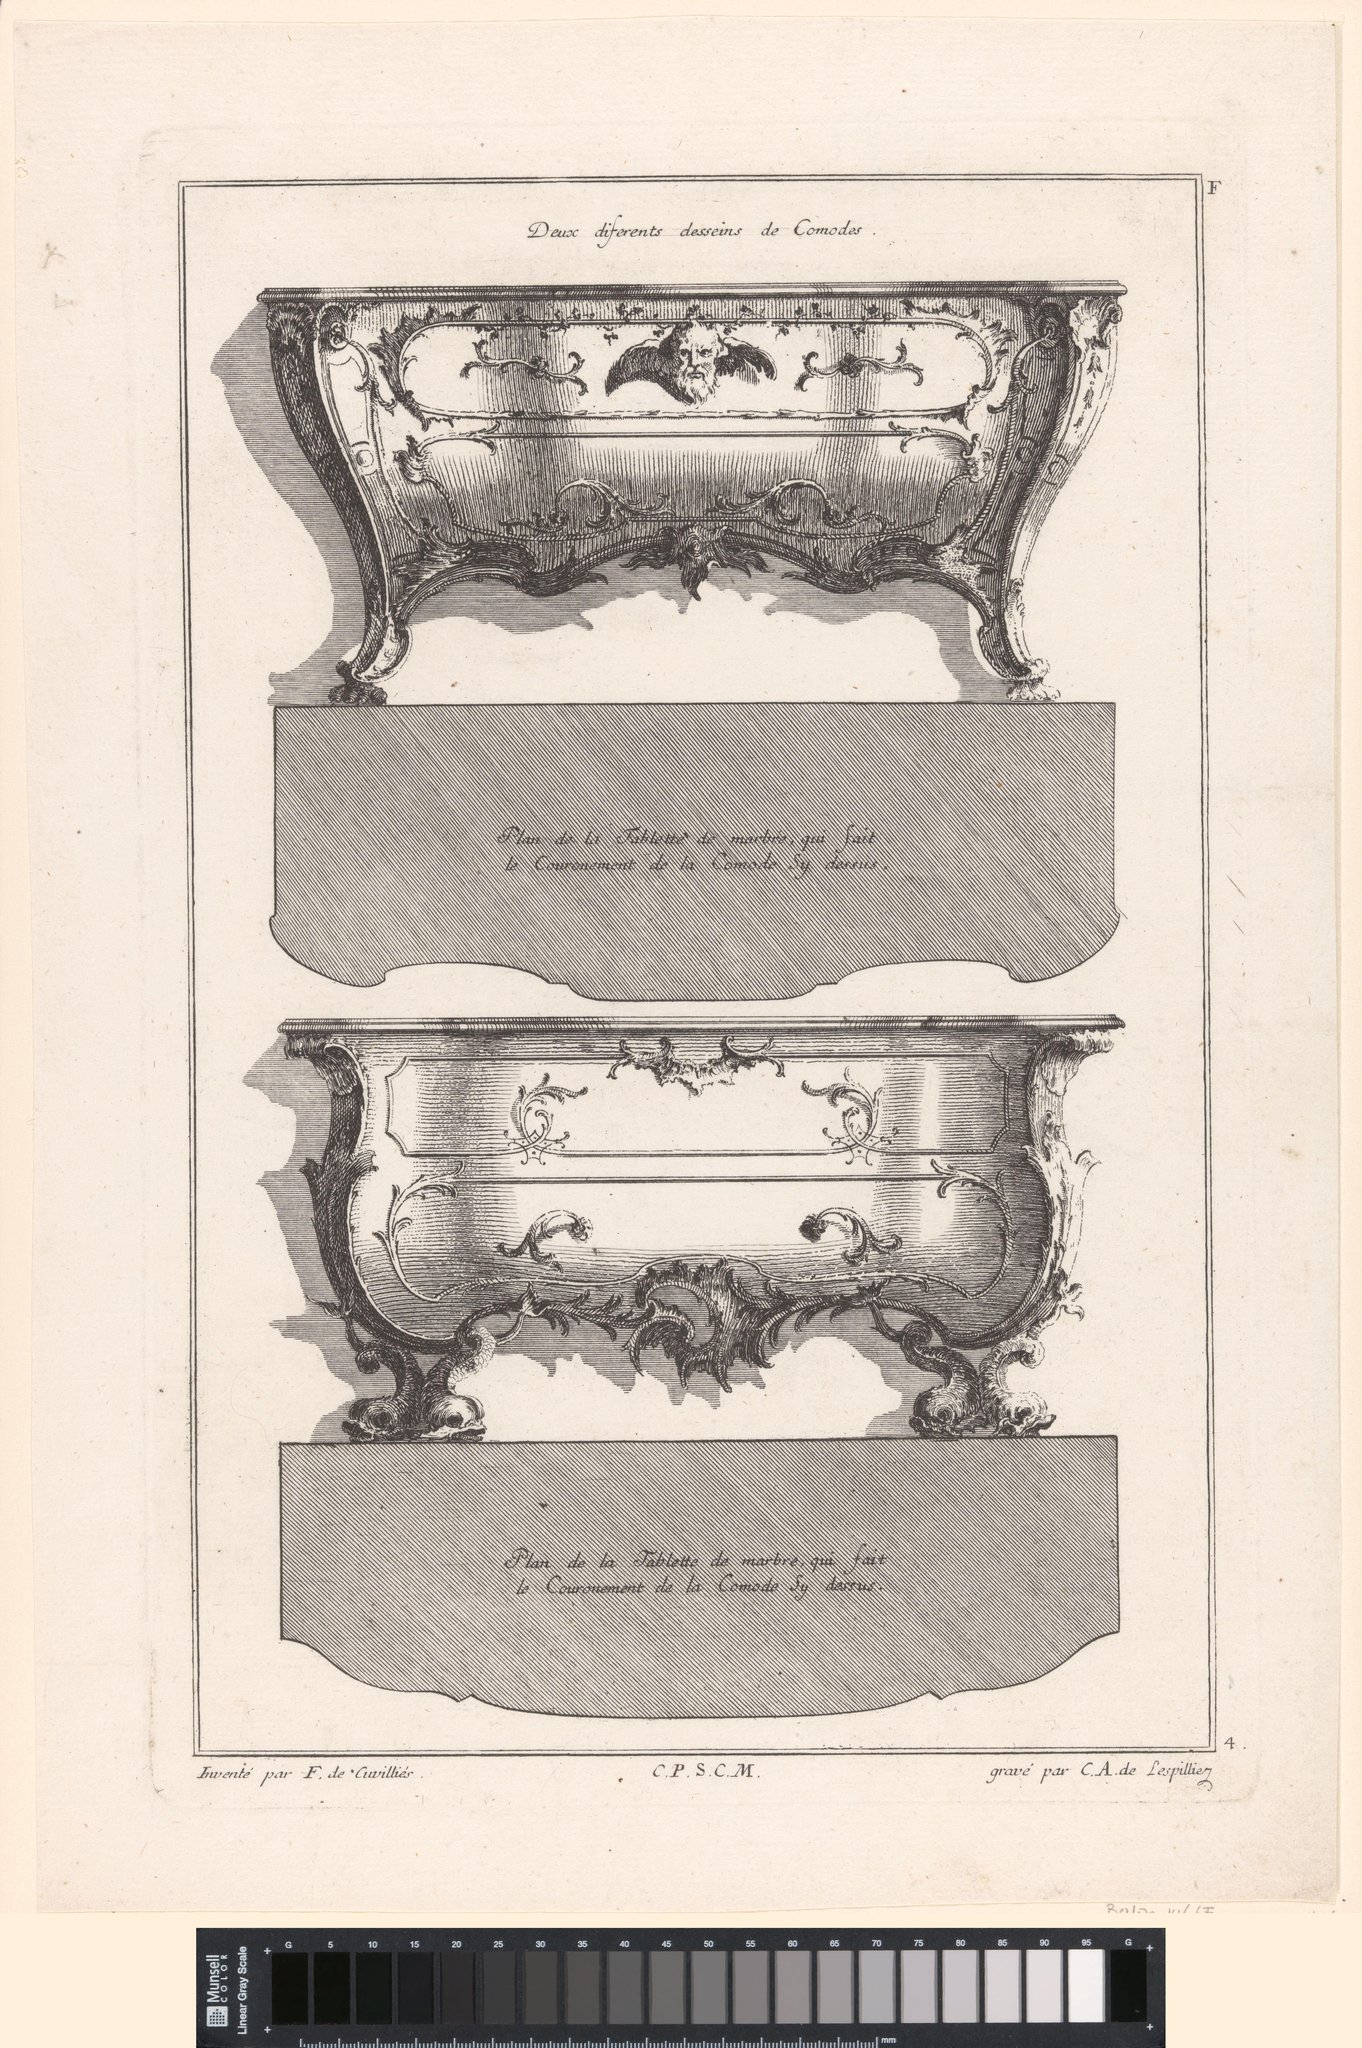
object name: print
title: Commodes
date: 1745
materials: paper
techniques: etching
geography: germany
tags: ornamental cupboard, dolphin ~ ornament, mask, mascaron ~ ornament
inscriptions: collector's mark: Lugt 2228, collector's mark: Lugt 2760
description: Voor- en bovenaanzichten van twee geornamenteerde commodes met rocailles, boven met mannelijk masker met baard, onder met dolfijnen.